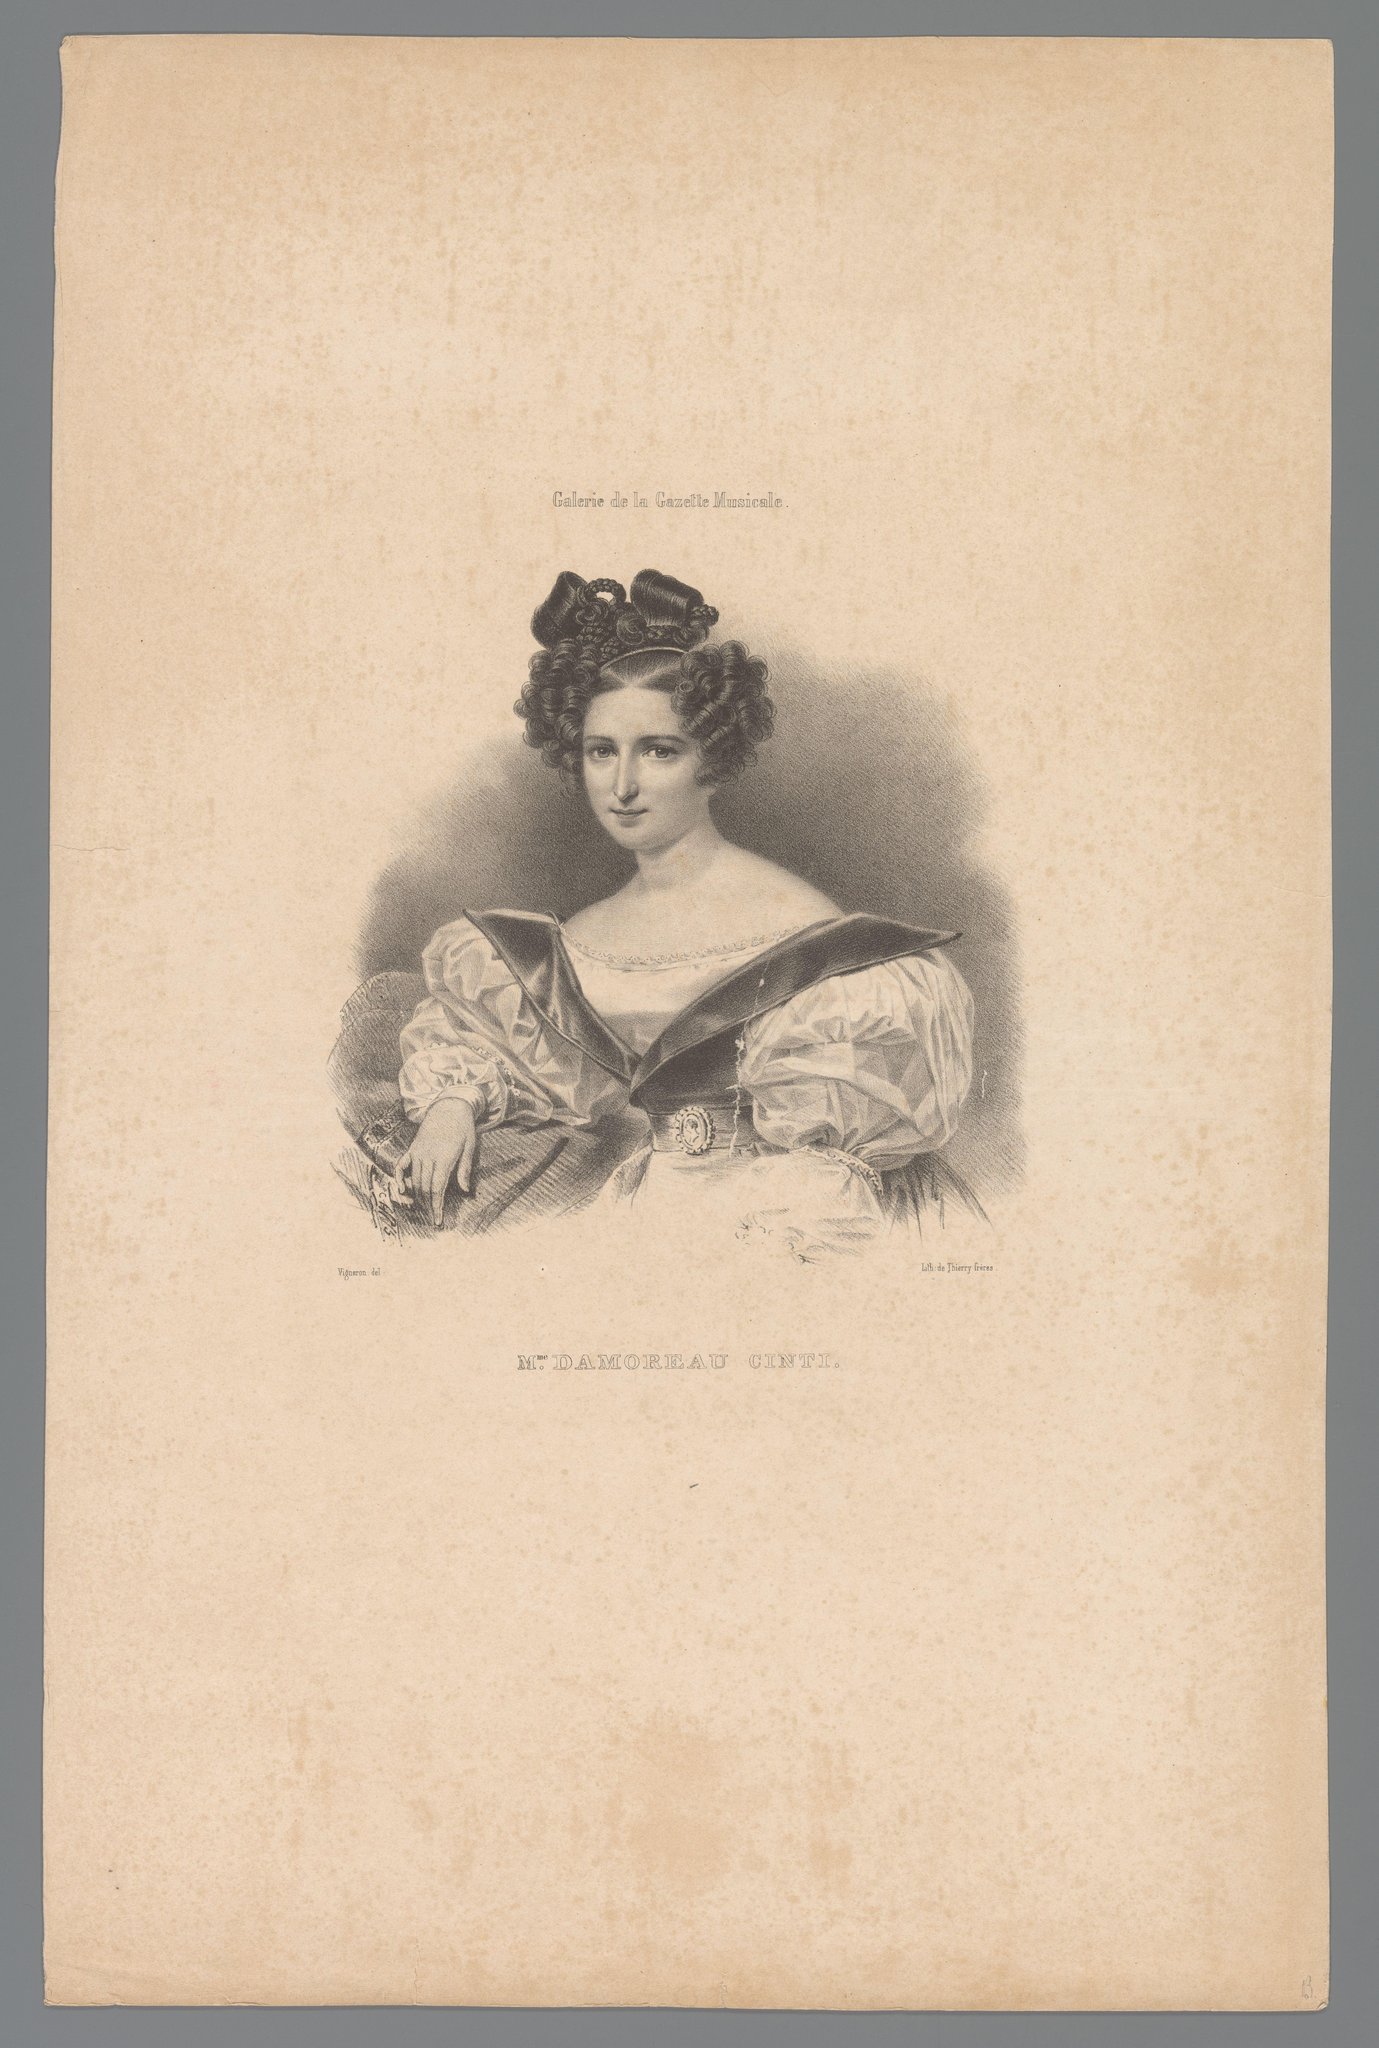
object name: print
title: Portret van operazangeres Laure Cinti-Damoreau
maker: pierre roch vigneron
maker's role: print maker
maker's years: 1789-1872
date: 1840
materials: paper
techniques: lithograph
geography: paris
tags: historical persons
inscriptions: collector's mark: Lugt 2228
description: Prent uit: Galerie de la Gazette Musicale 7 (1840), nr. 64, 15 november 1840.